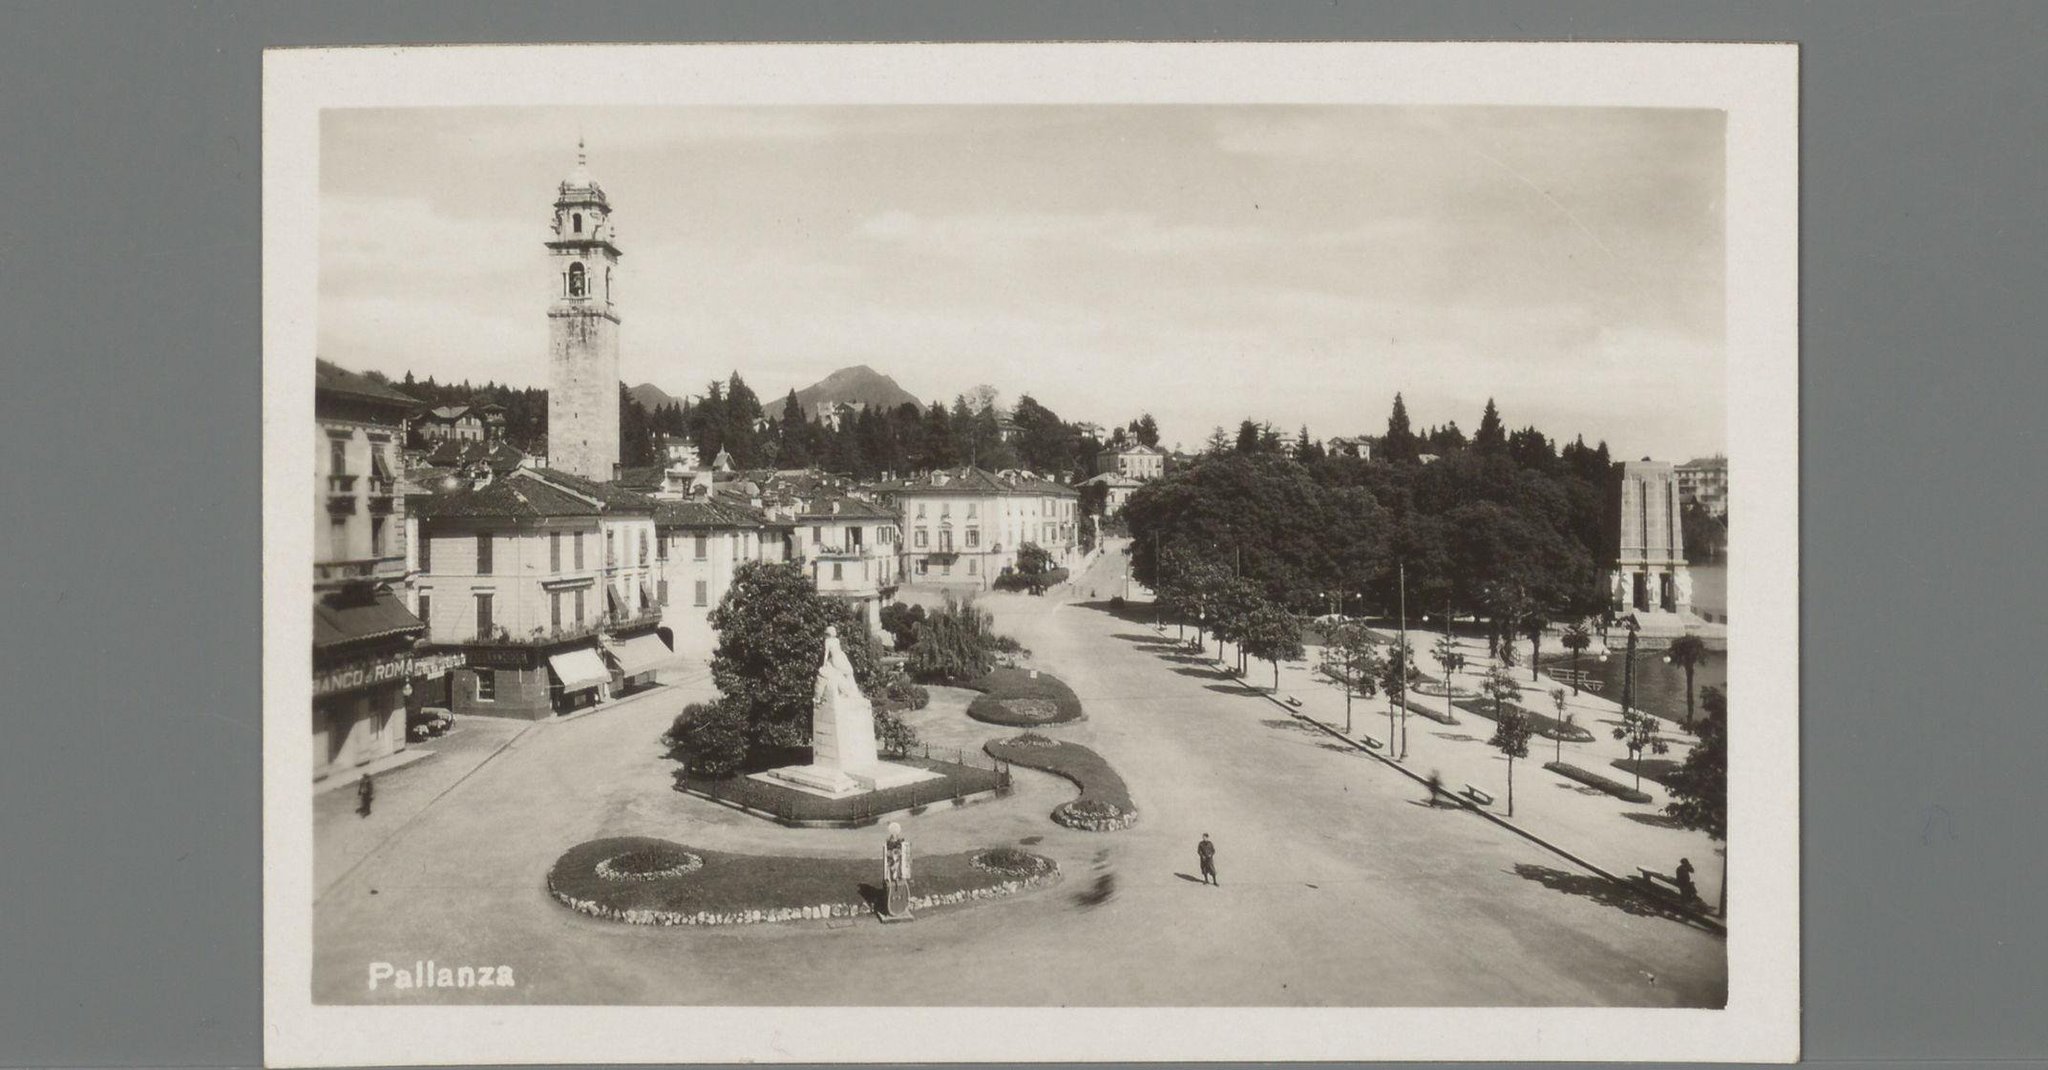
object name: photograph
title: Pallanza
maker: Anonymous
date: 1904-1935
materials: photographic support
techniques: photography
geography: como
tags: church (exterior), city-view, and landscape with man-made constructions (+ city(-scape) with figures, staffage)